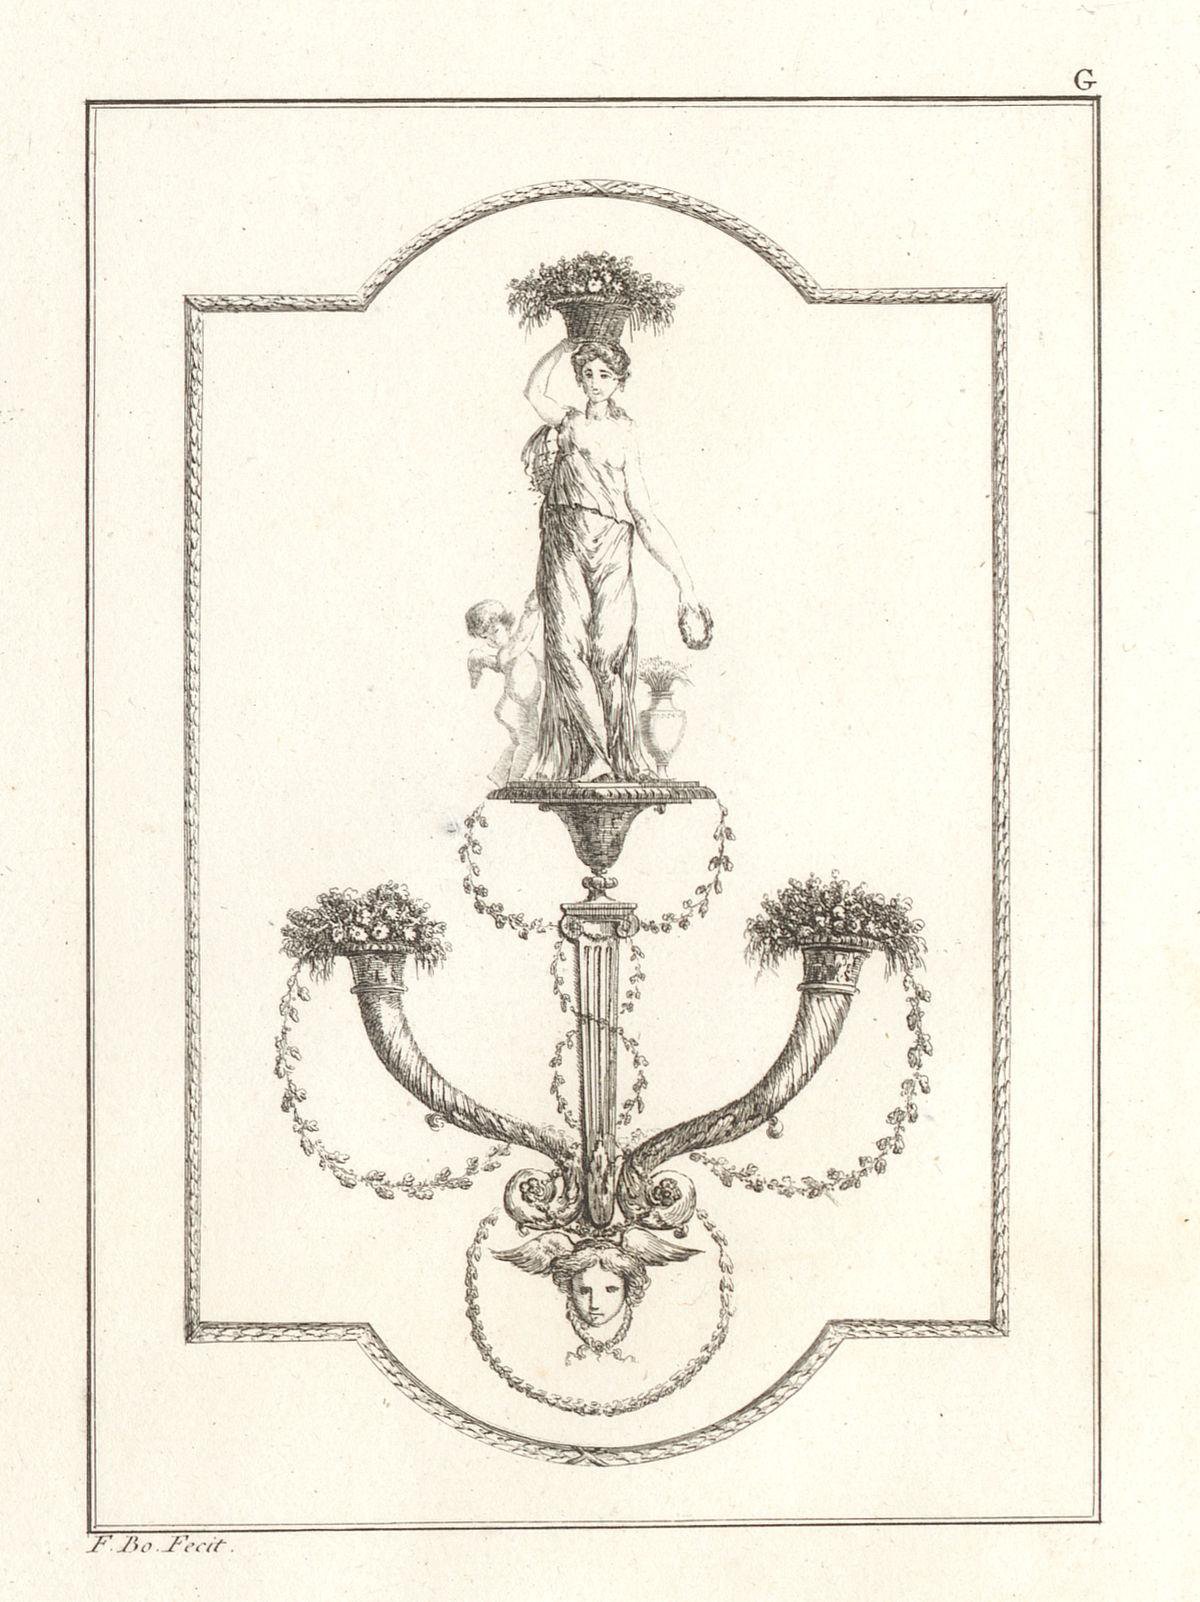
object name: print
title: Ornament van een vrouw op een sokkel boven cornucopia en een masker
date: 1802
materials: paper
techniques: etching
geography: paris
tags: 'cornucopia', horn of plenty, ornament ~ arabesque, vase ~ ornament, mask, mascaron ~ ornament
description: Doordat dit album bestaat uit meerdere, deels eerder uitgegeven prentreeksen, is de datering niet consequent. Het geheel is op de titelpagina gedateerd op 1802. Deze reeks is niet los gedateerd. De serietitel voor het gehele werk is "Recueil d'arabesques, contenant les loges du Vatican". De andere serietitel is de titel van de specifieke reeks binnen het geheel.